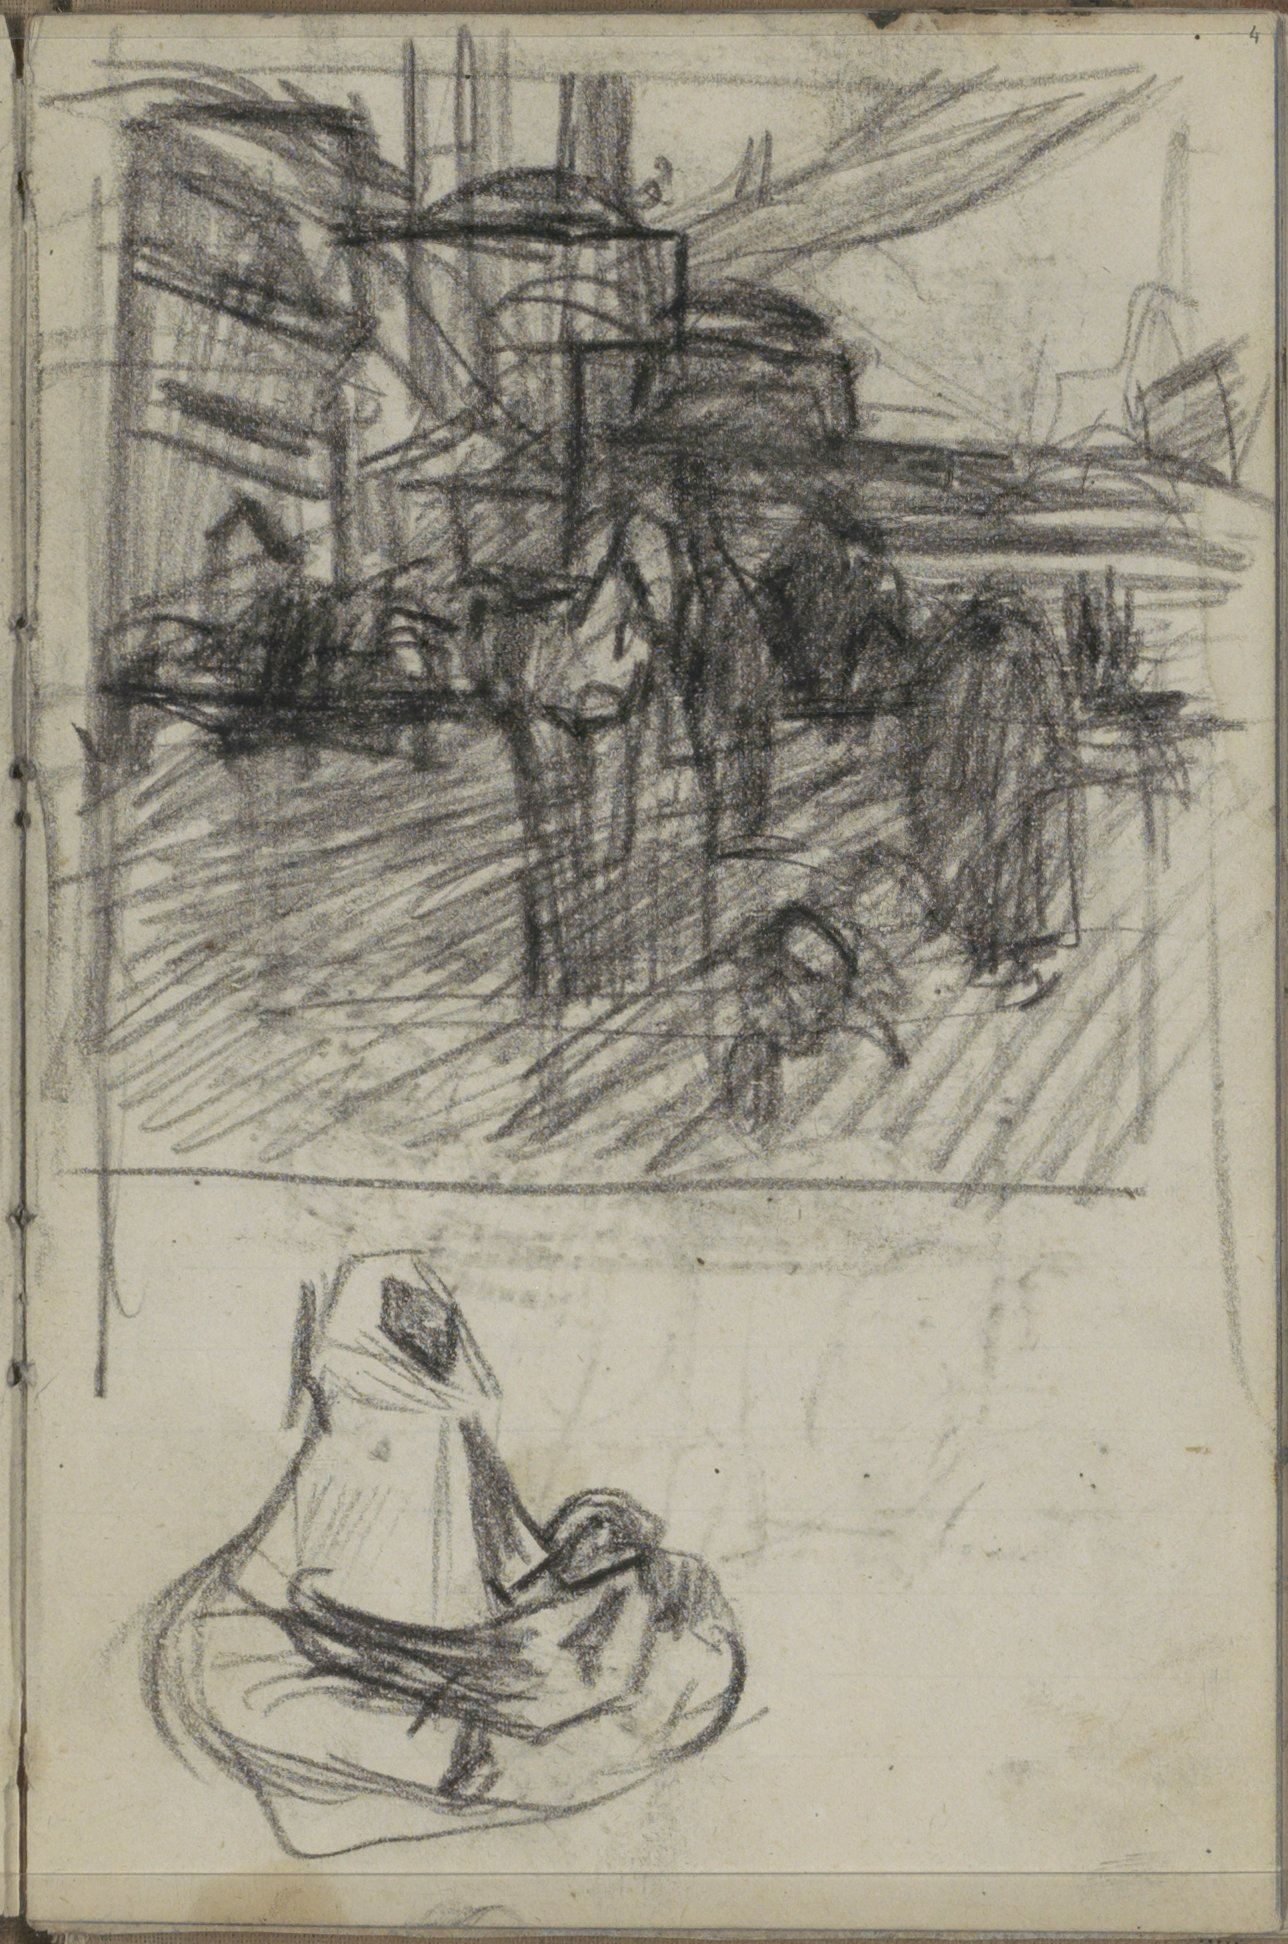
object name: sketchbook leaf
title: Studieblad, onder andere met een straat met figuren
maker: marius bauer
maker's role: draughtsman, print maker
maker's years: 1867-1932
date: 1888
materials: chalk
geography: istanbul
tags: other methods of carrying children, street (+ city(-scape) with figures, staffage)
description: Tevens een studie van een figuur met een kind in de armen. Pagina 4 uit een schetsboek met 58 bladen.